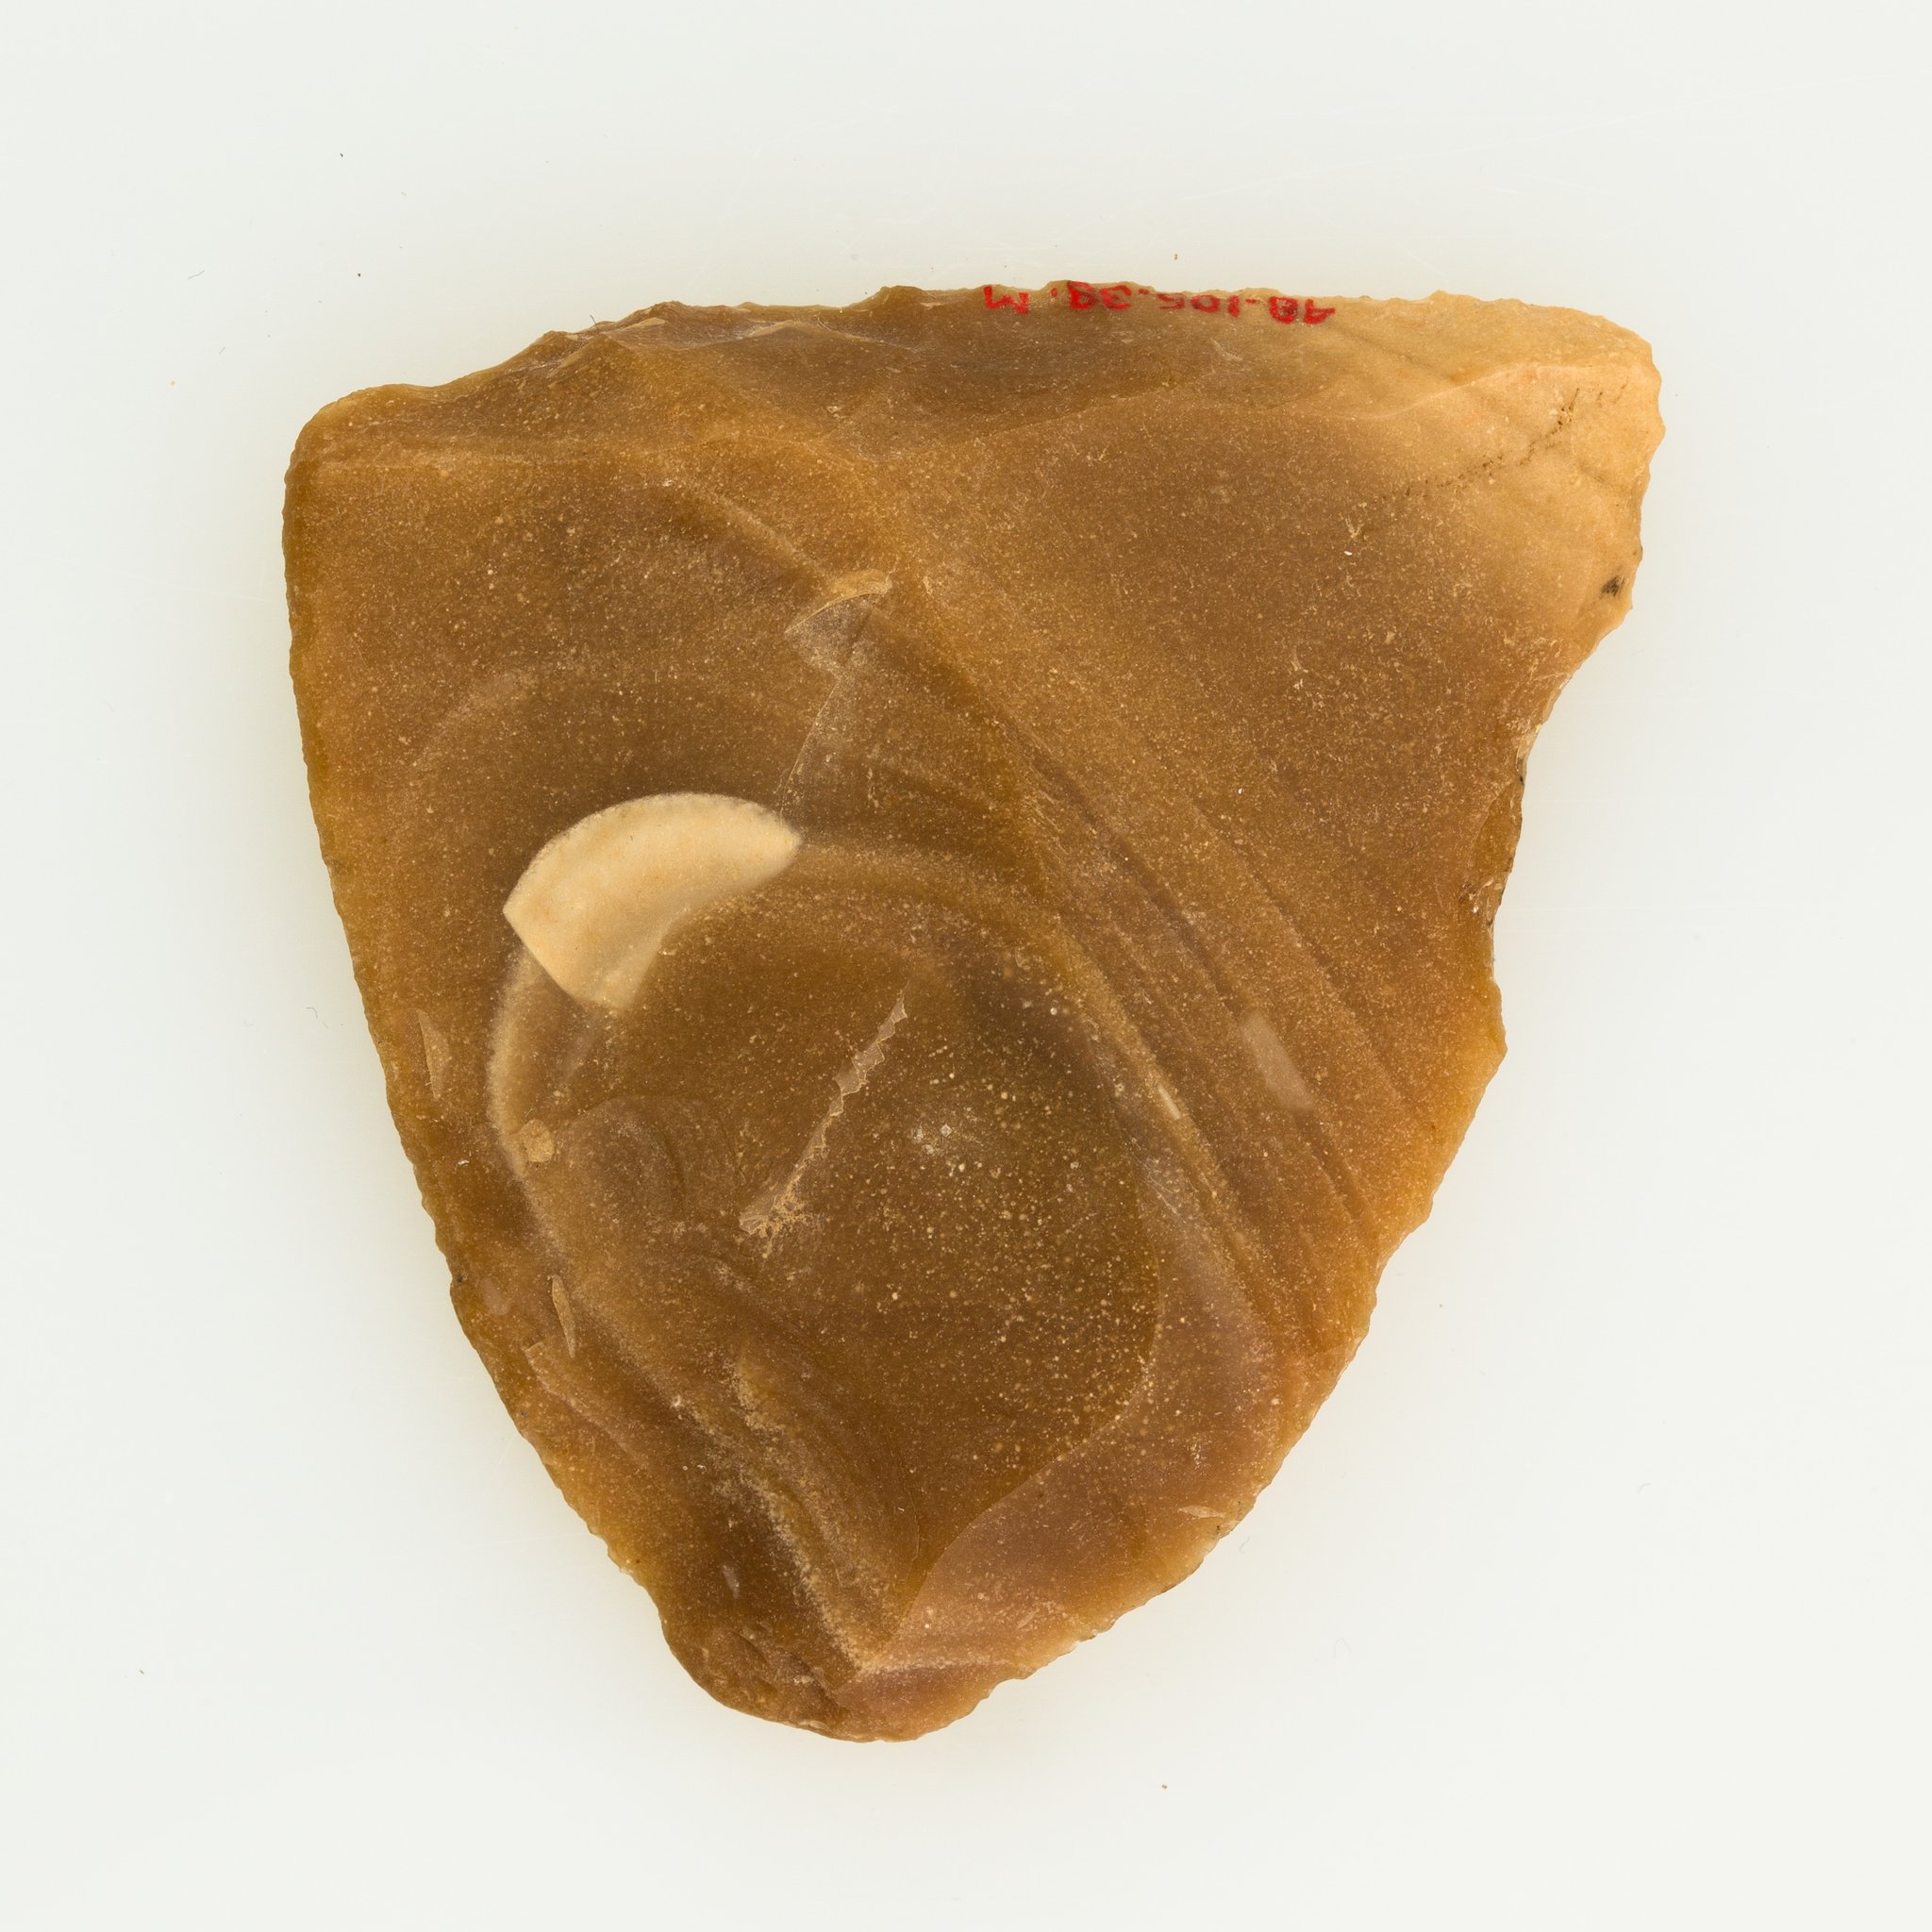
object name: scraper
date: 1184-664 BCE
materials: stone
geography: egypt